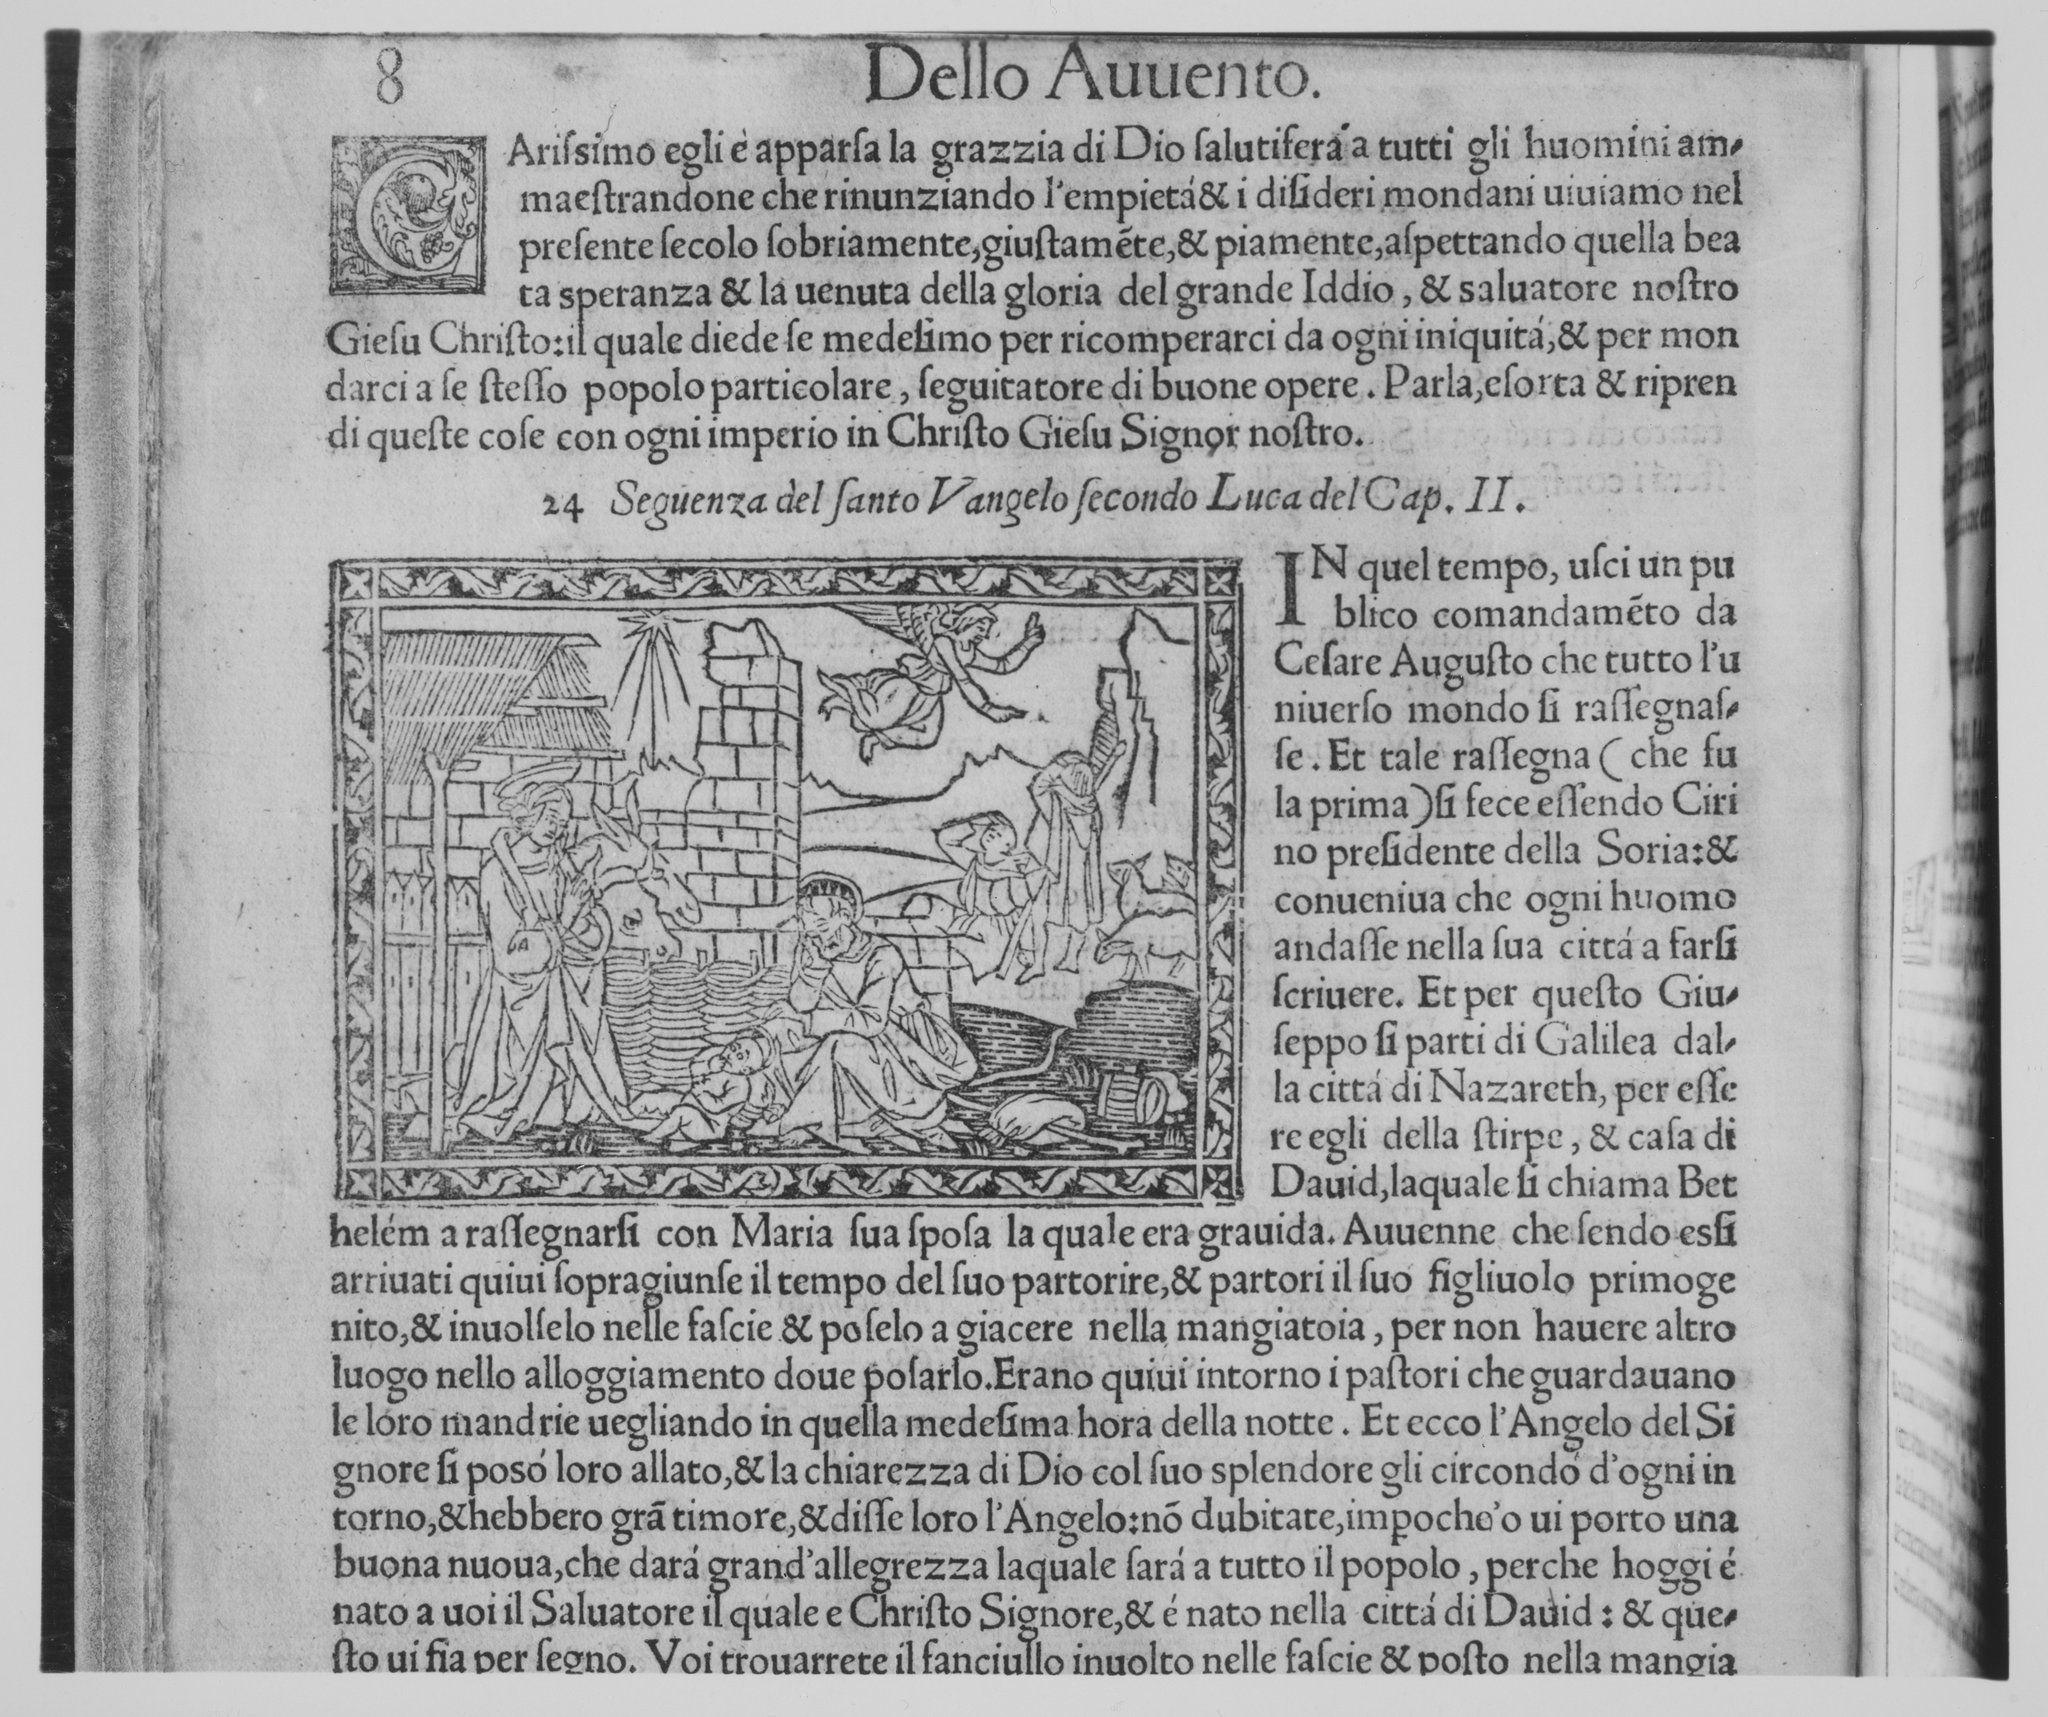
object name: book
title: Pistole, Lezzioni, et Vangeli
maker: da giunta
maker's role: publisher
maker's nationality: italian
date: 1565-1566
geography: italy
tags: animals,infants,men